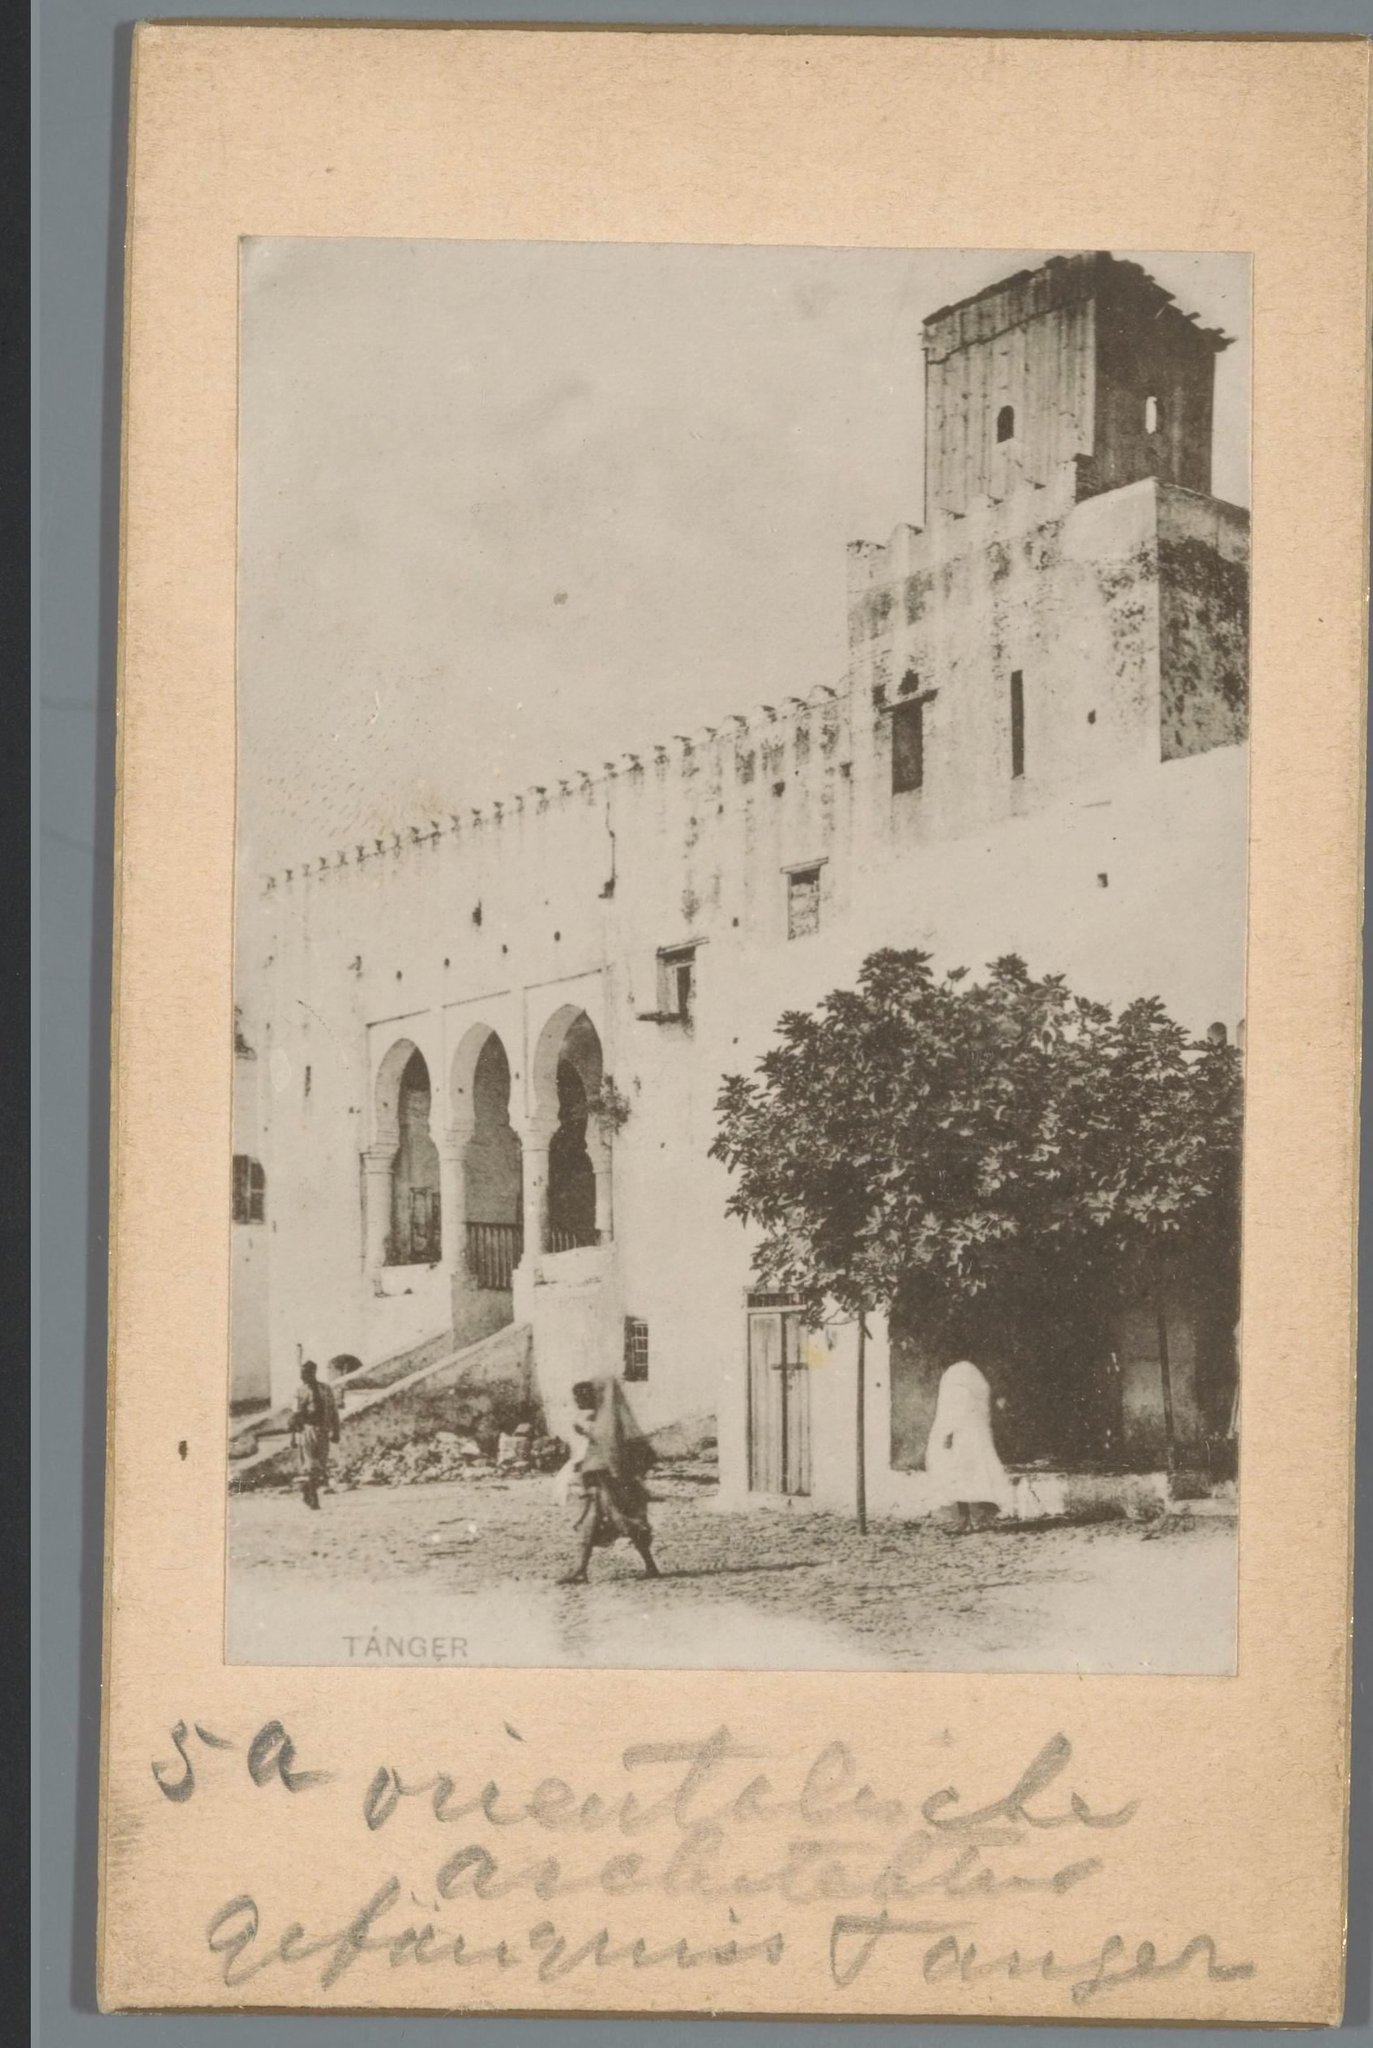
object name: photograph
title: Gevangenis aan het Place de la Kasbah, Tanger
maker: Anonymous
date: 1890-1920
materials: paper, cardboard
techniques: gelatin silver print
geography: tanger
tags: prison, jail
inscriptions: number: ‘5a’, inscription: ‘Tánger’